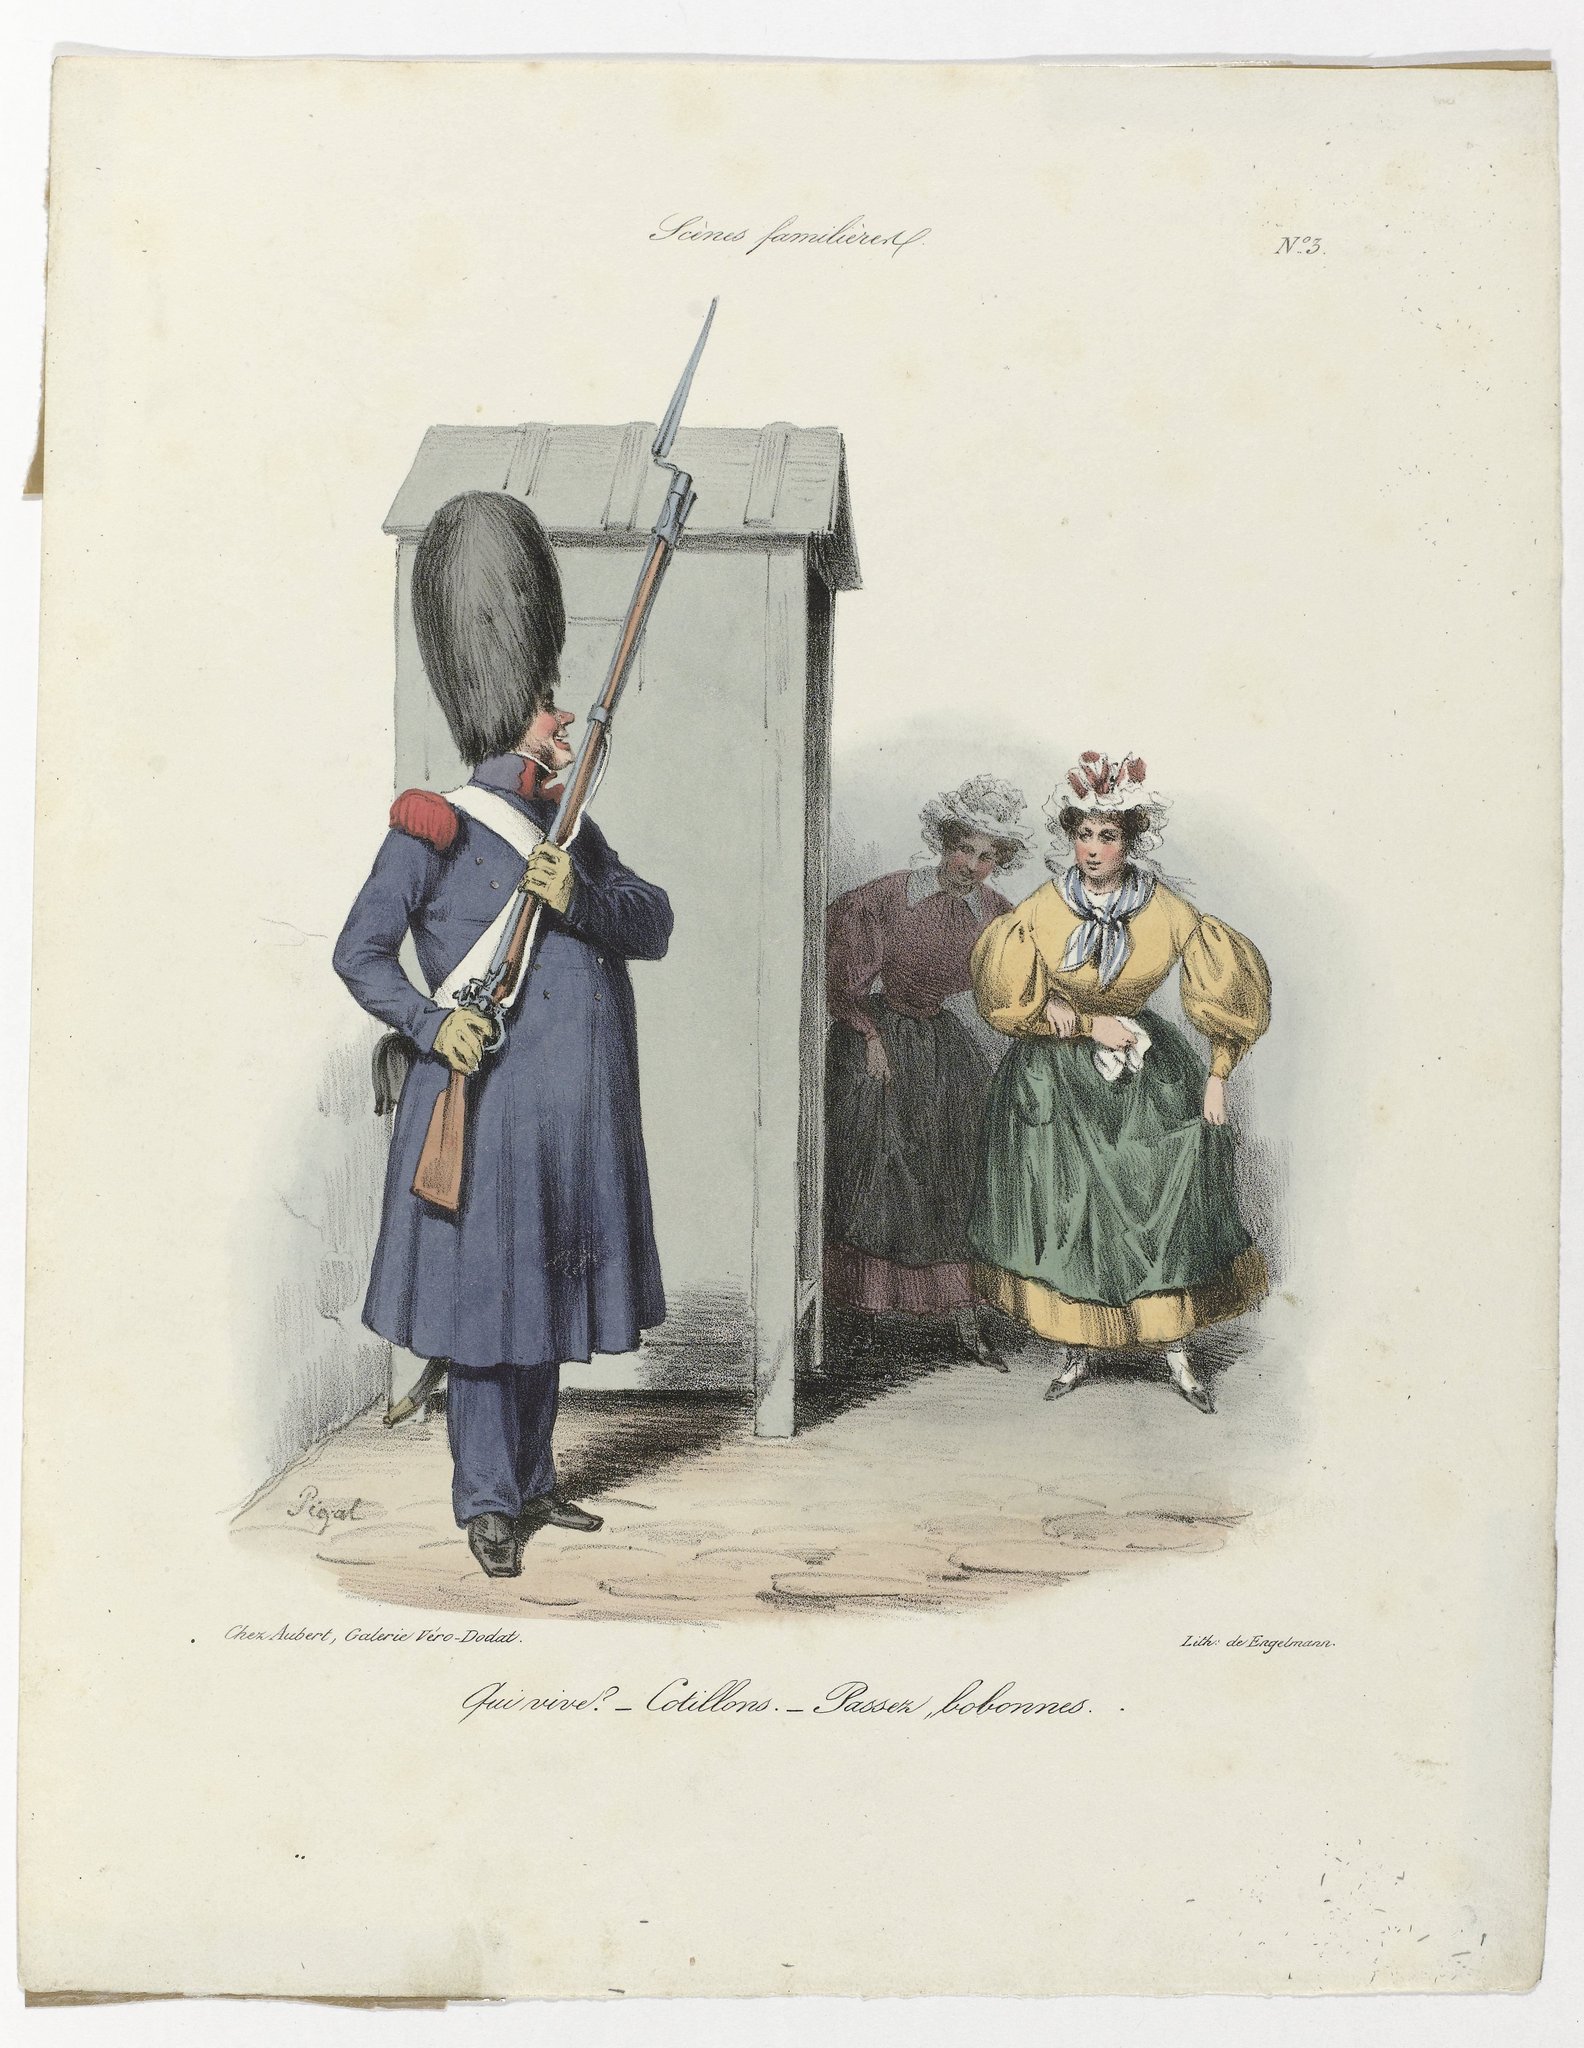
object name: caricature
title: Scènes familières, ca. 1830, No. 3 : Qui vive?-Cotillons (...)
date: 1830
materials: paper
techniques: hand coloring, lithograph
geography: paris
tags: dress, gown (+ women's clothes), firearms, (military) uniforms, apron (+ women's clothes)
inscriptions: caption: ‘Qui vive? _ Cotillons. _ Passez, bobonnes.’, title: ‘Scènes familières’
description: Twee vrouwen lopen langs een wachthuisje waarnaast een soldaat met bajonet.